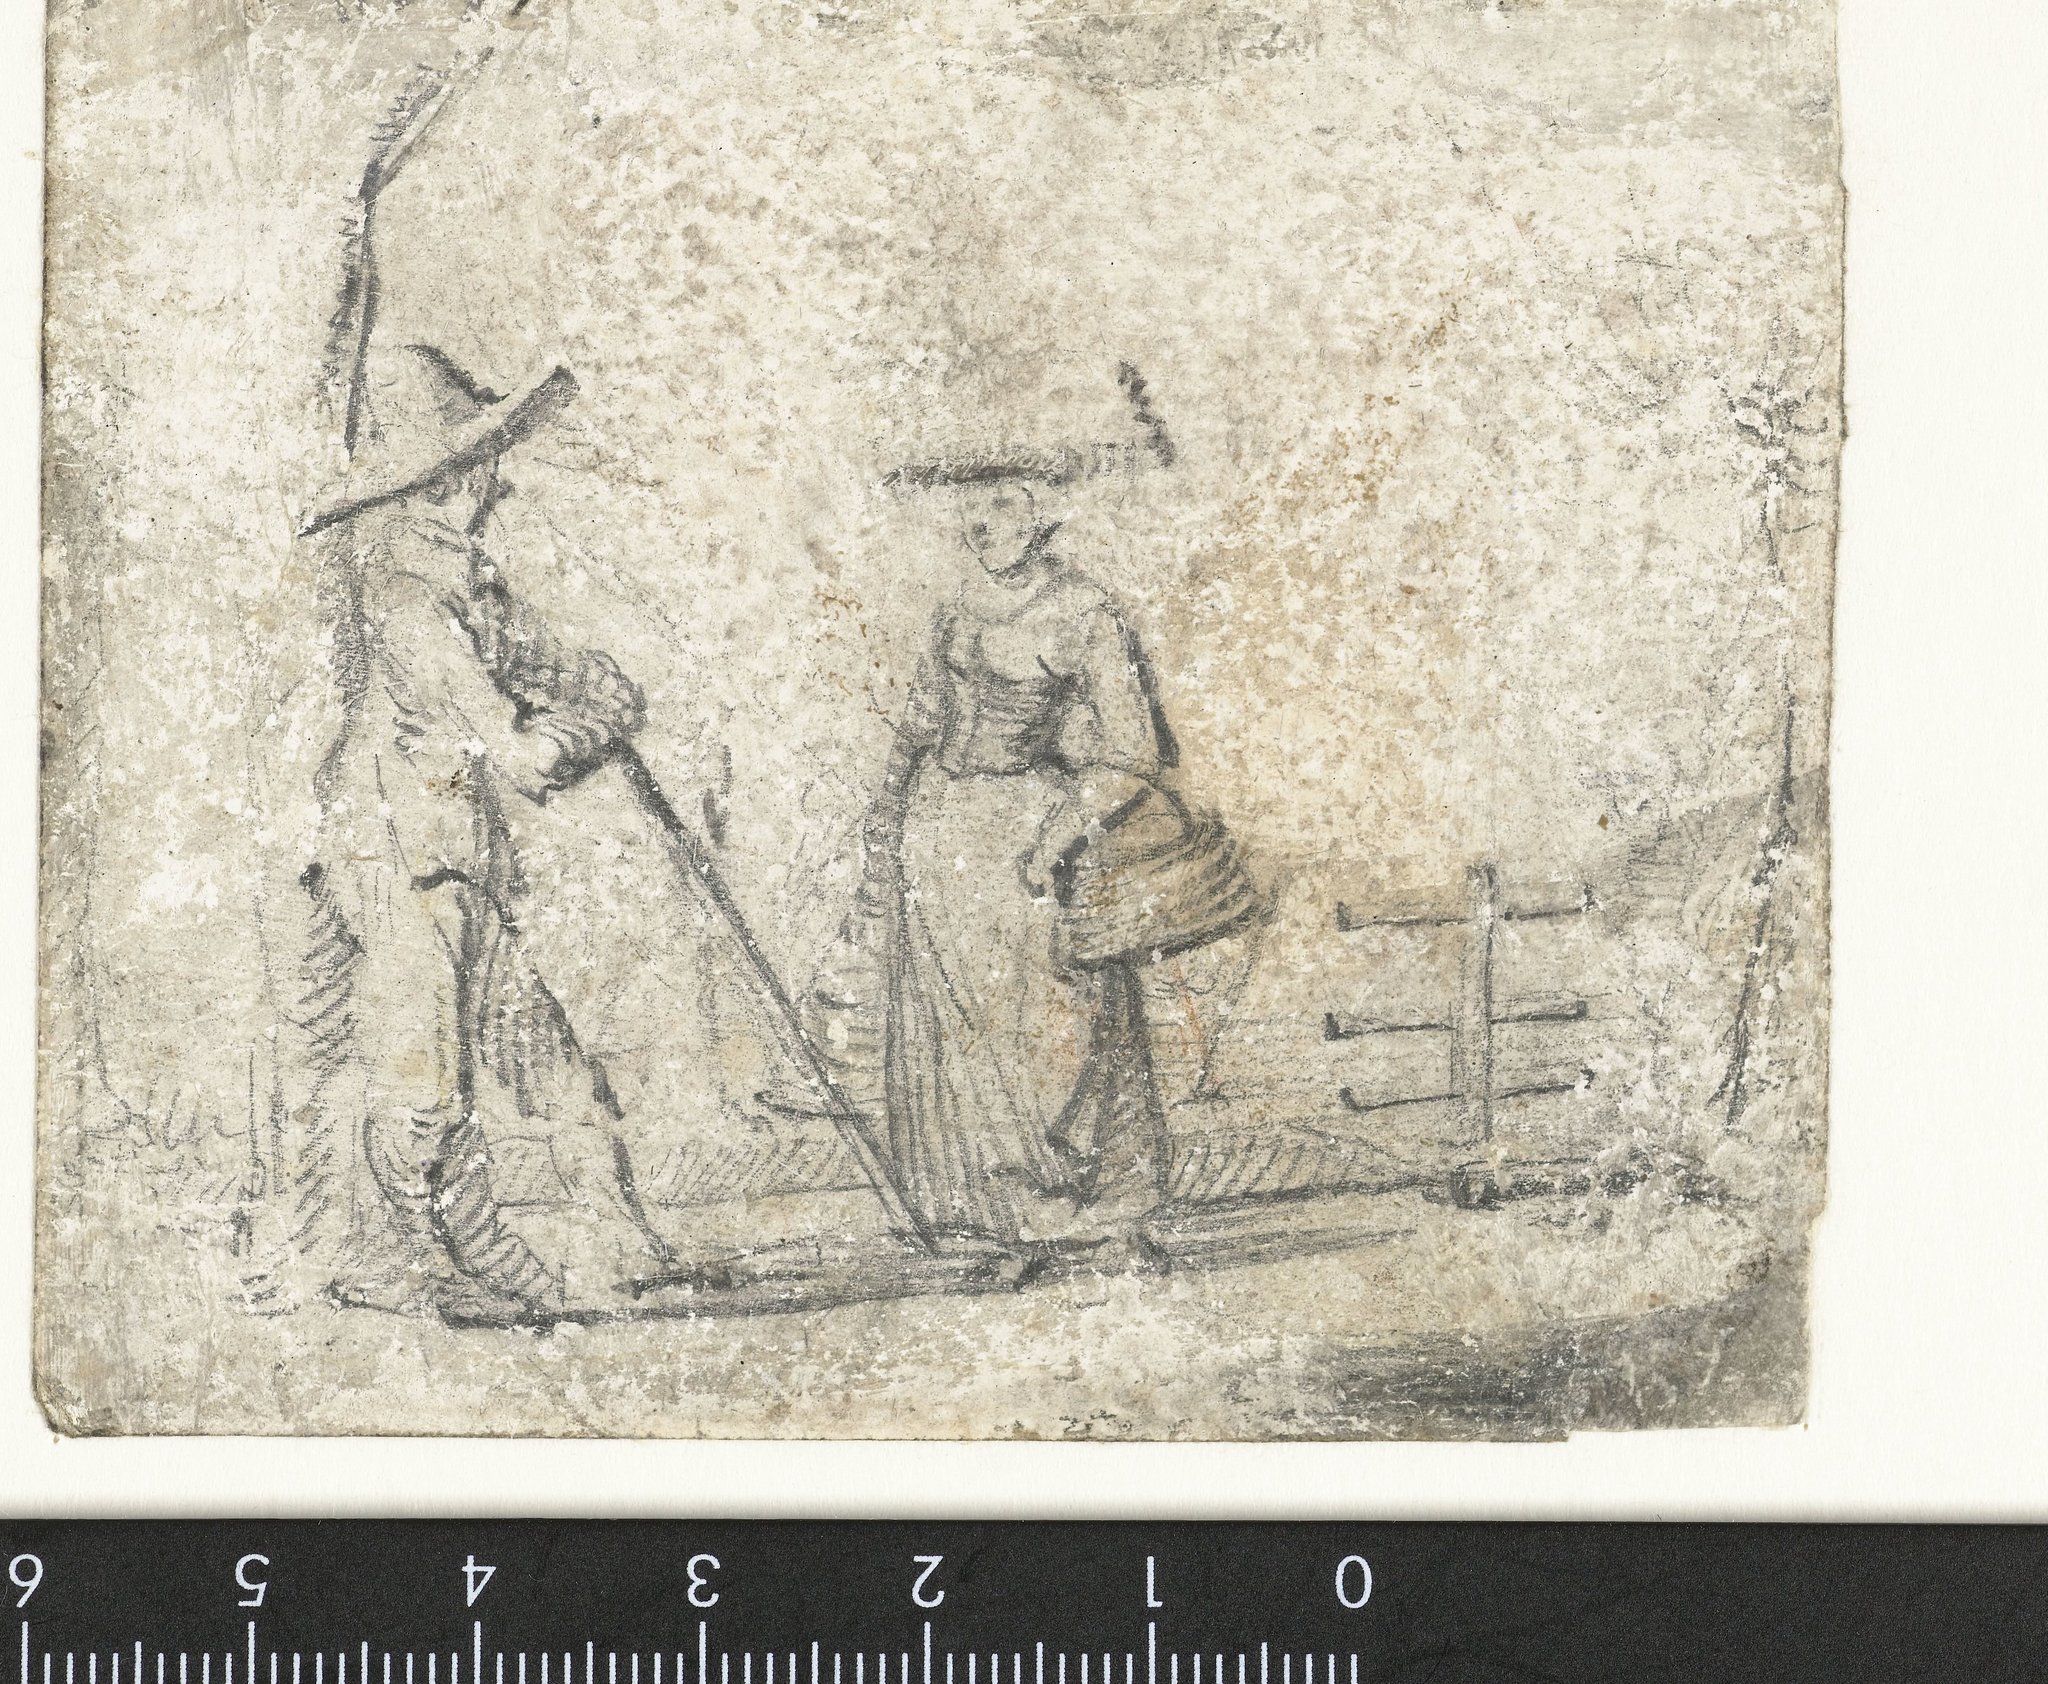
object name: drawing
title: Man en vrouw pratend bij een hek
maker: harmen ter borch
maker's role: draughtsman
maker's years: 1638-1677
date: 1650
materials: pencil, paper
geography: zwolle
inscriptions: annotation: ‘Ger jr.(?)’